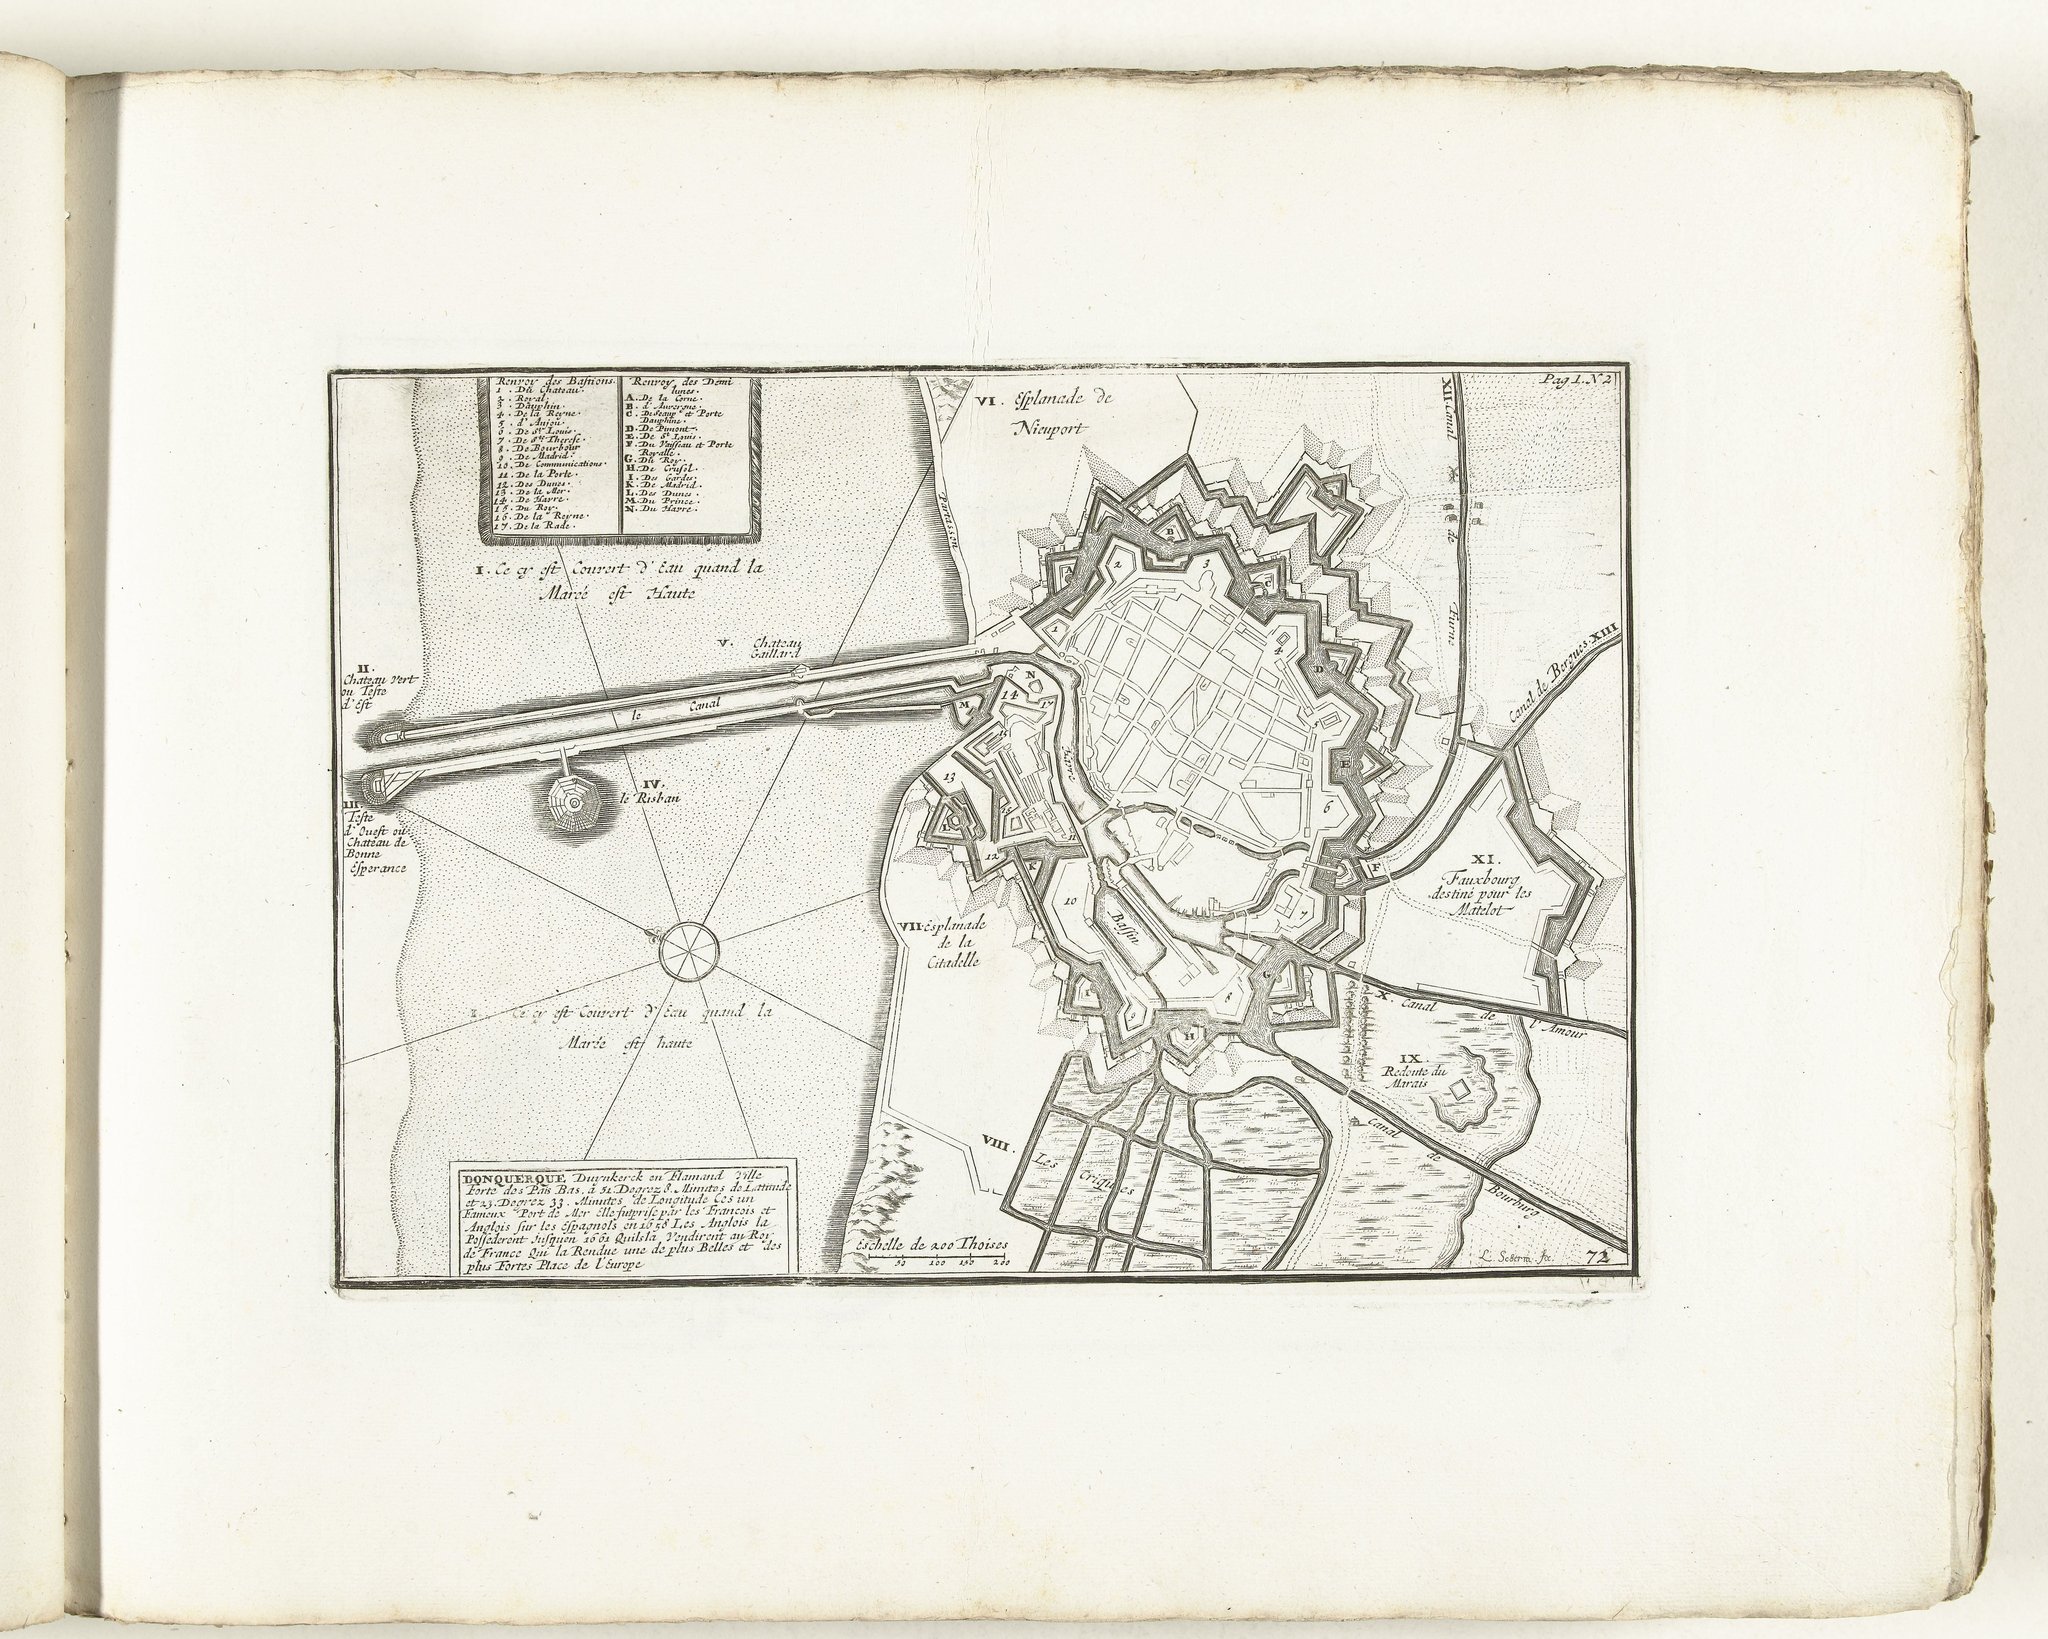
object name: print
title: Les Forces de l'Europe, Asie, Afrique et Amerique, ou description des principales villes avec leurs fortifications. Dessignées par les meilleurs ingenieurs, particulierement celles qui sont sous la domination de la France (...) et ornées de plusieurs superbes edifices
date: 1702-1703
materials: paper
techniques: etching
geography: amsterdam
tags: fortress, maps of cities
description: Plattegrond van de verdedigingswerken om de stad Duinkerke. Gemerkt rechtsboven: Pag. 1. N2. Plaat nr. 72 in het prentwerk bestaande in totaal uit 276 genummerde platen van vermaarde sterke steden en vestingen in het kader van de Spaanse Successieoorlog. Voor het merendeel zijn deze platen gekopieerd naar de anonieme Franse platen: in Les forces de l'Europe en in: Le theatre de la guerre, dans les Pays-Bas, beide oorspronkelijk uitgegeven door Nicolas de Fer te Parijs (1693-1697) in het kader van de Negenjarige Oorlog. Titel en opschriften in de plaat in het Frans.